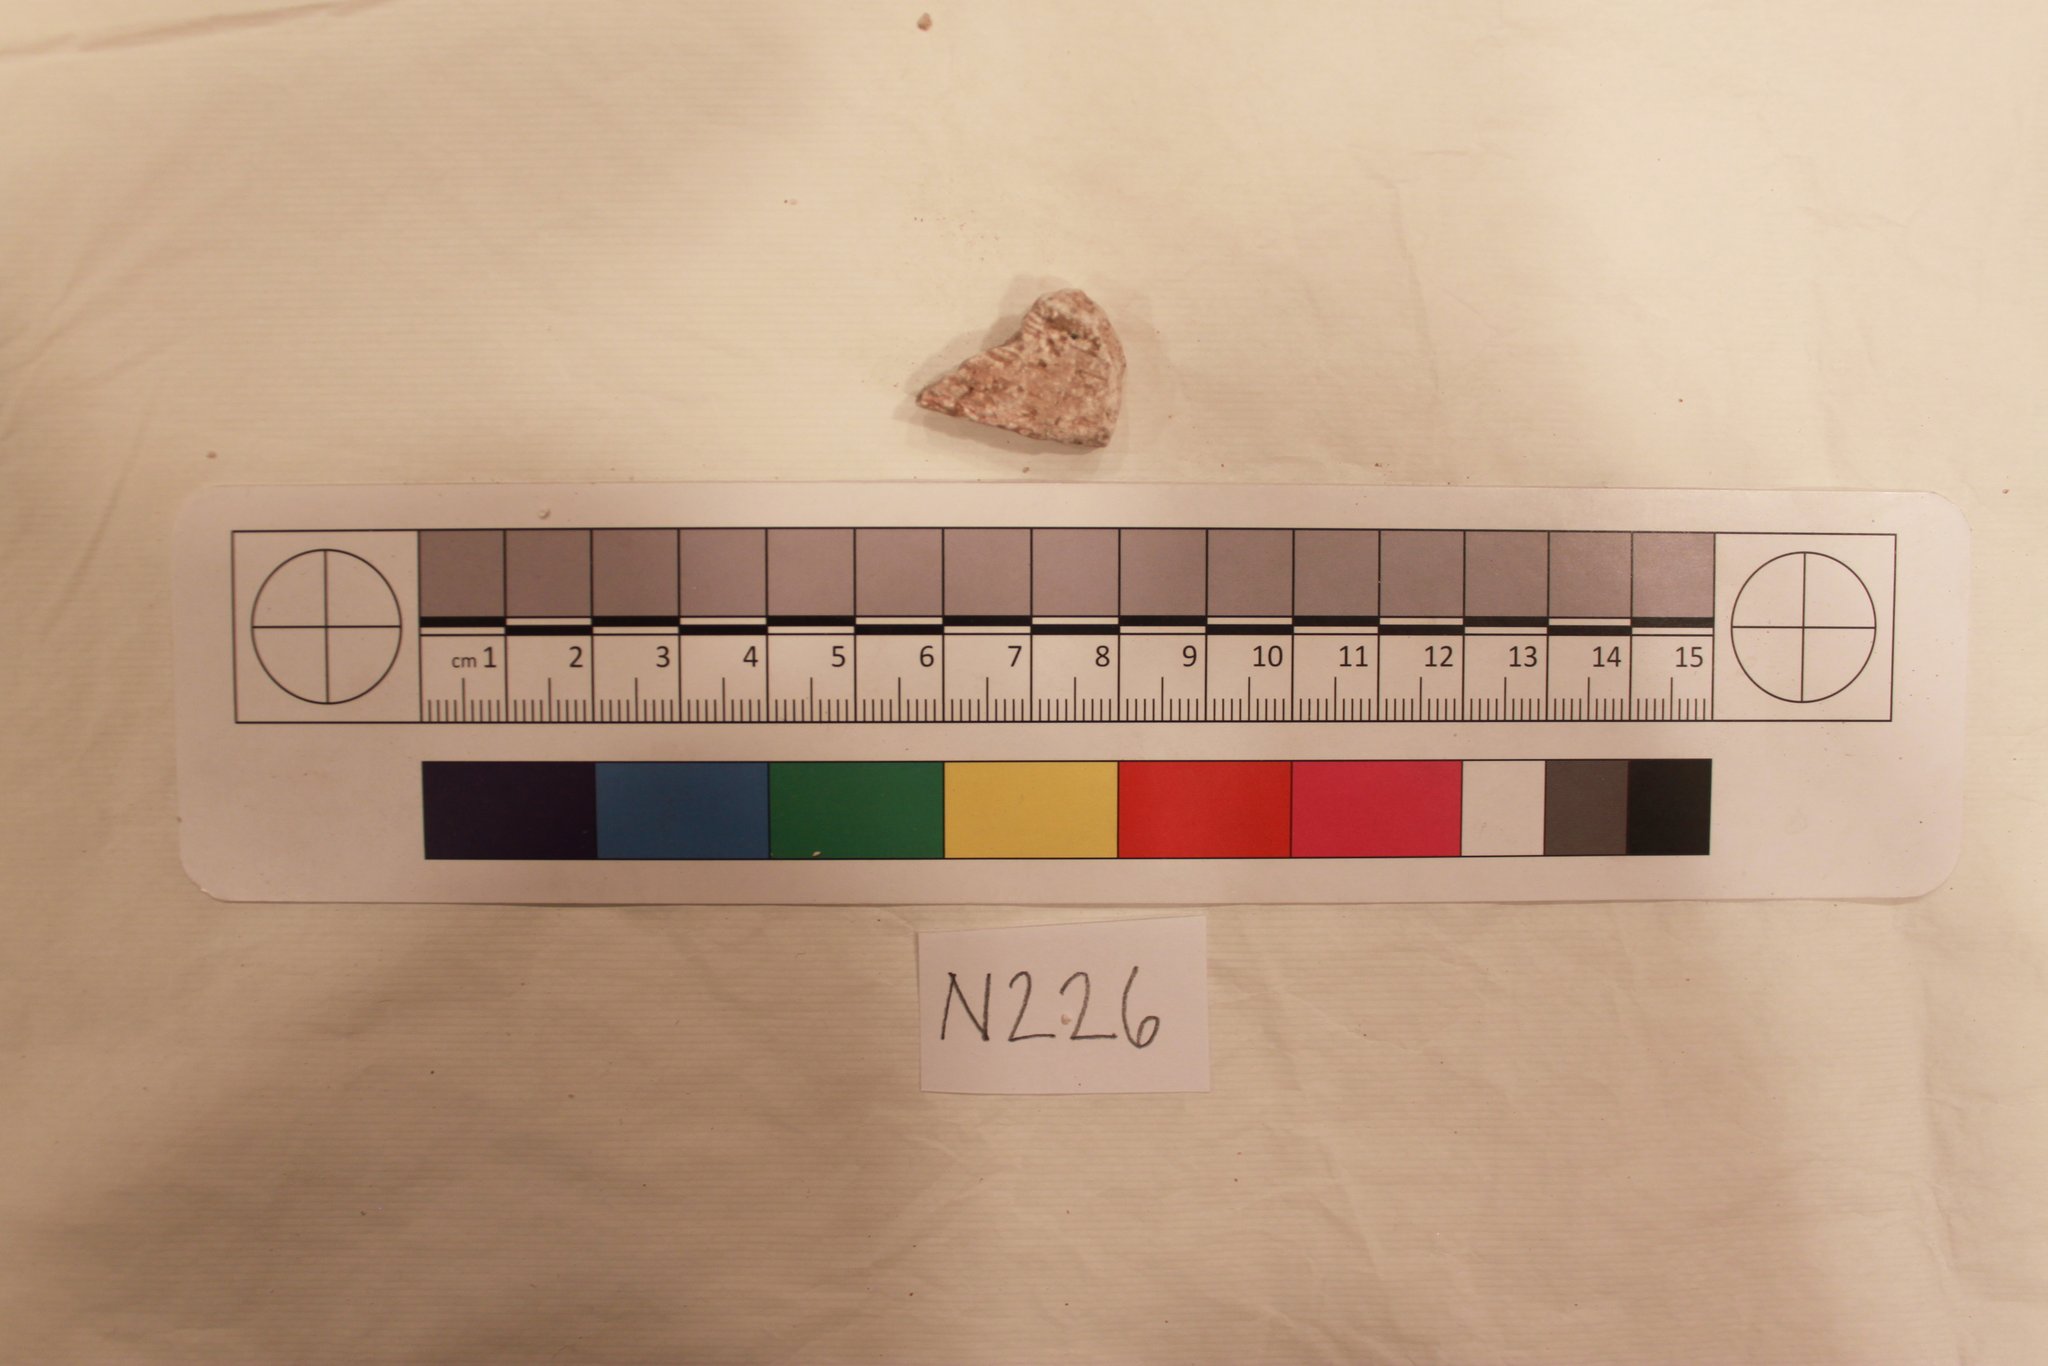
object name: fragment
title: Stucco Fragment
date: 701-1200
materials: plaster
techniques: carving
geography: iran